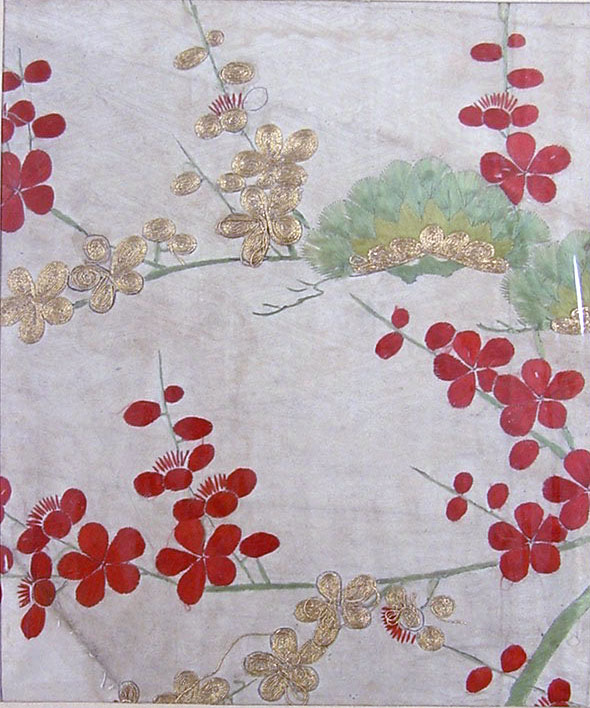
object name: piece from a kosode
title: Piece from a Kosode with Pine Bough and Blossoming Plum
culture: japanese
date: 1615-1868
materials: metal thread, silk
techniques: damask, embroidery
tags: flowers